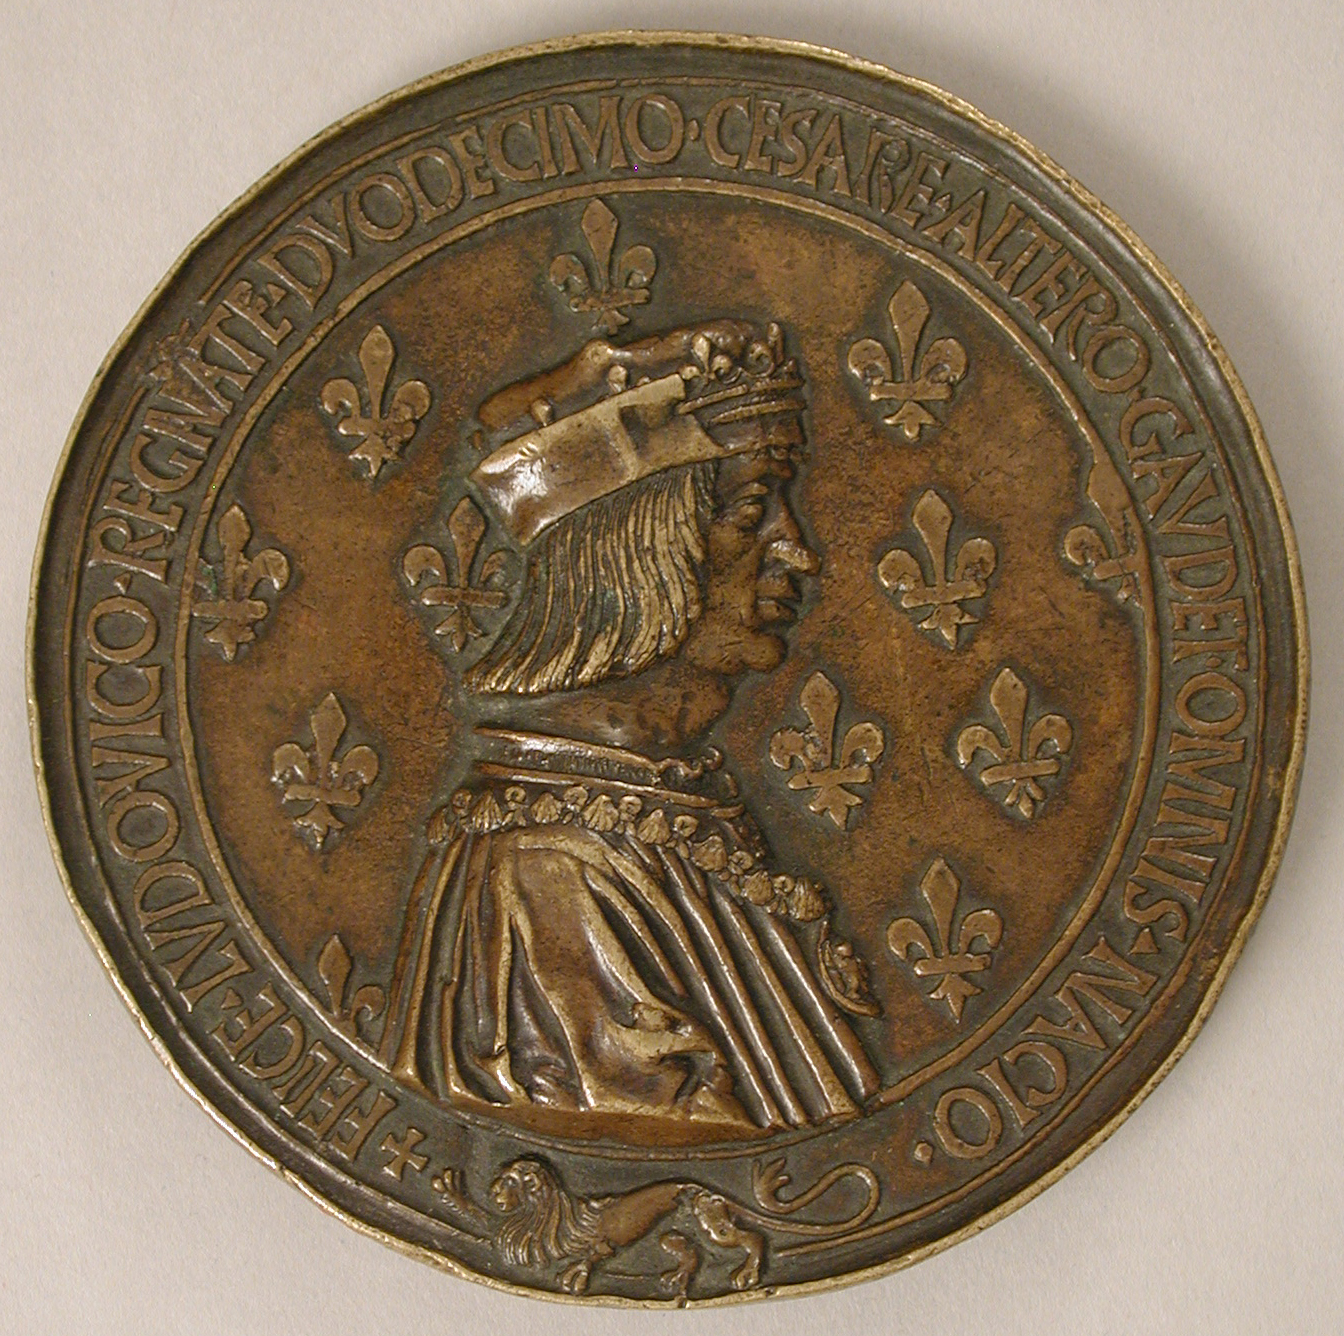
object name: medal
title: Medal Louis XII, King of France (r. 1498–15155), and Anne of Brittany (1476–1514)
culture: french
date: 1499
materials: copper alloy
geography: france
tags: men,profiles,women